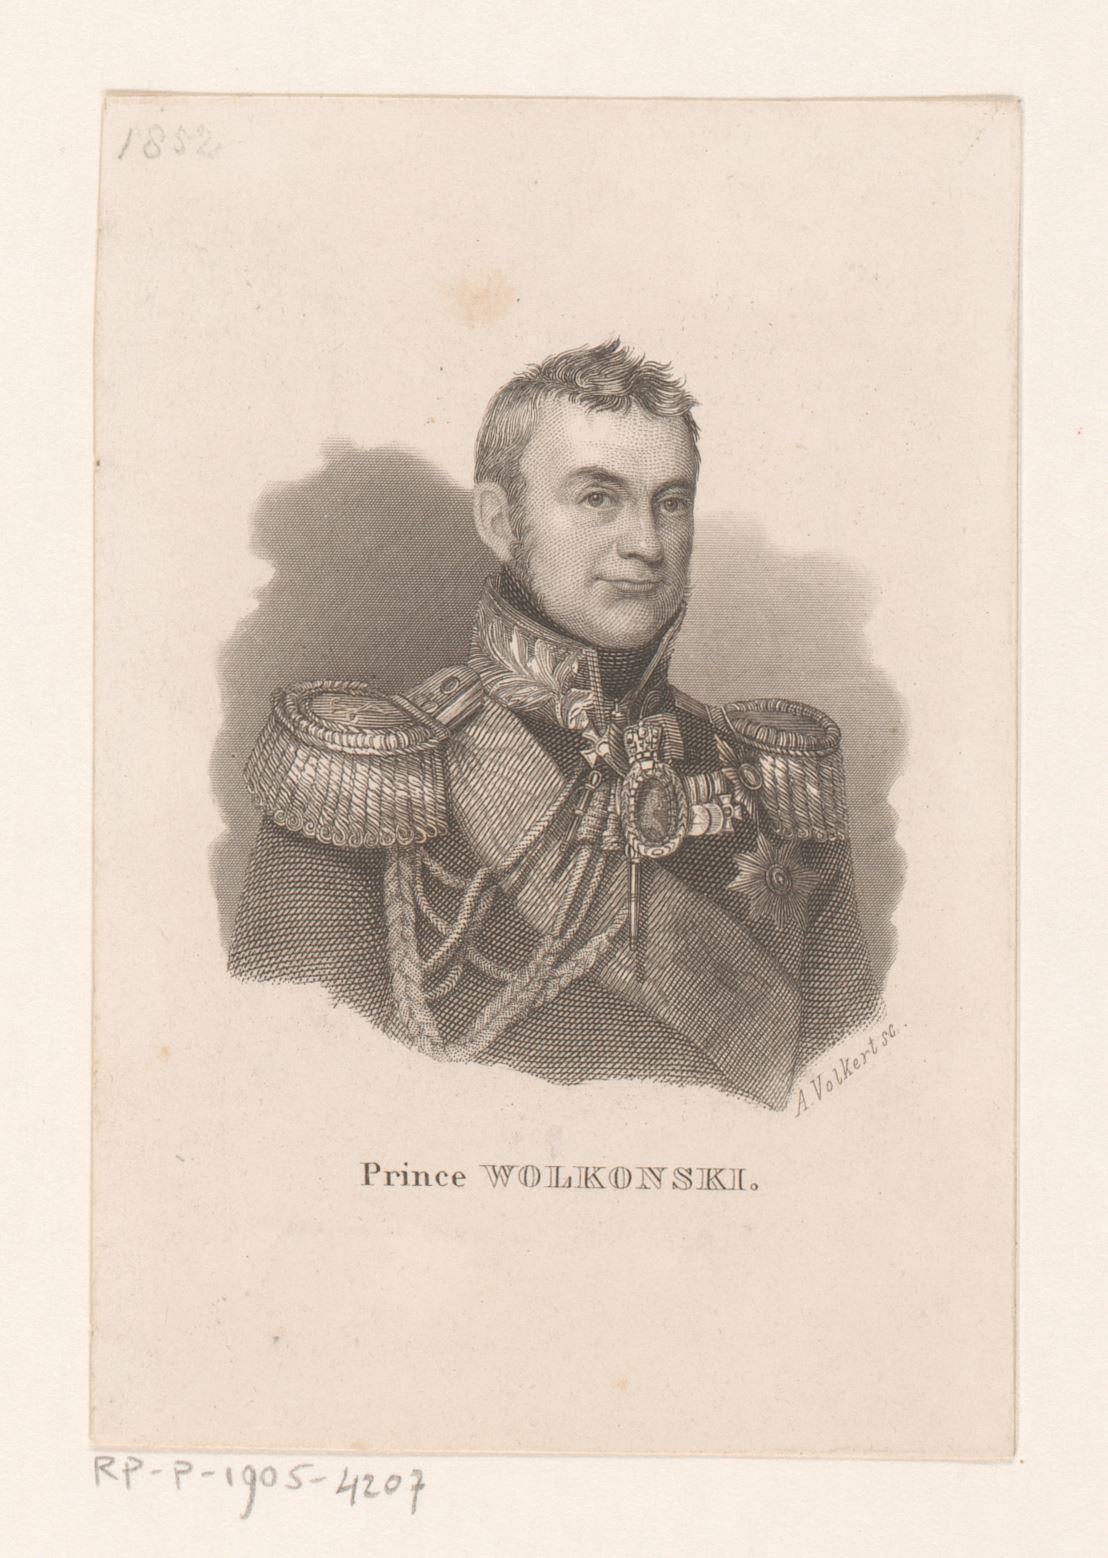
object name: print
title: Portret van Pyotr Mikhailovich Volkonsky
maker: august volkert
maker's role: print maker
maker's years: 1818-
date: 1852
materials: paper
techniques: engraving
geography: germany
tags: historical persons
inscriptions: inscription: ‘1851’, collector's mark: Lugt 2228